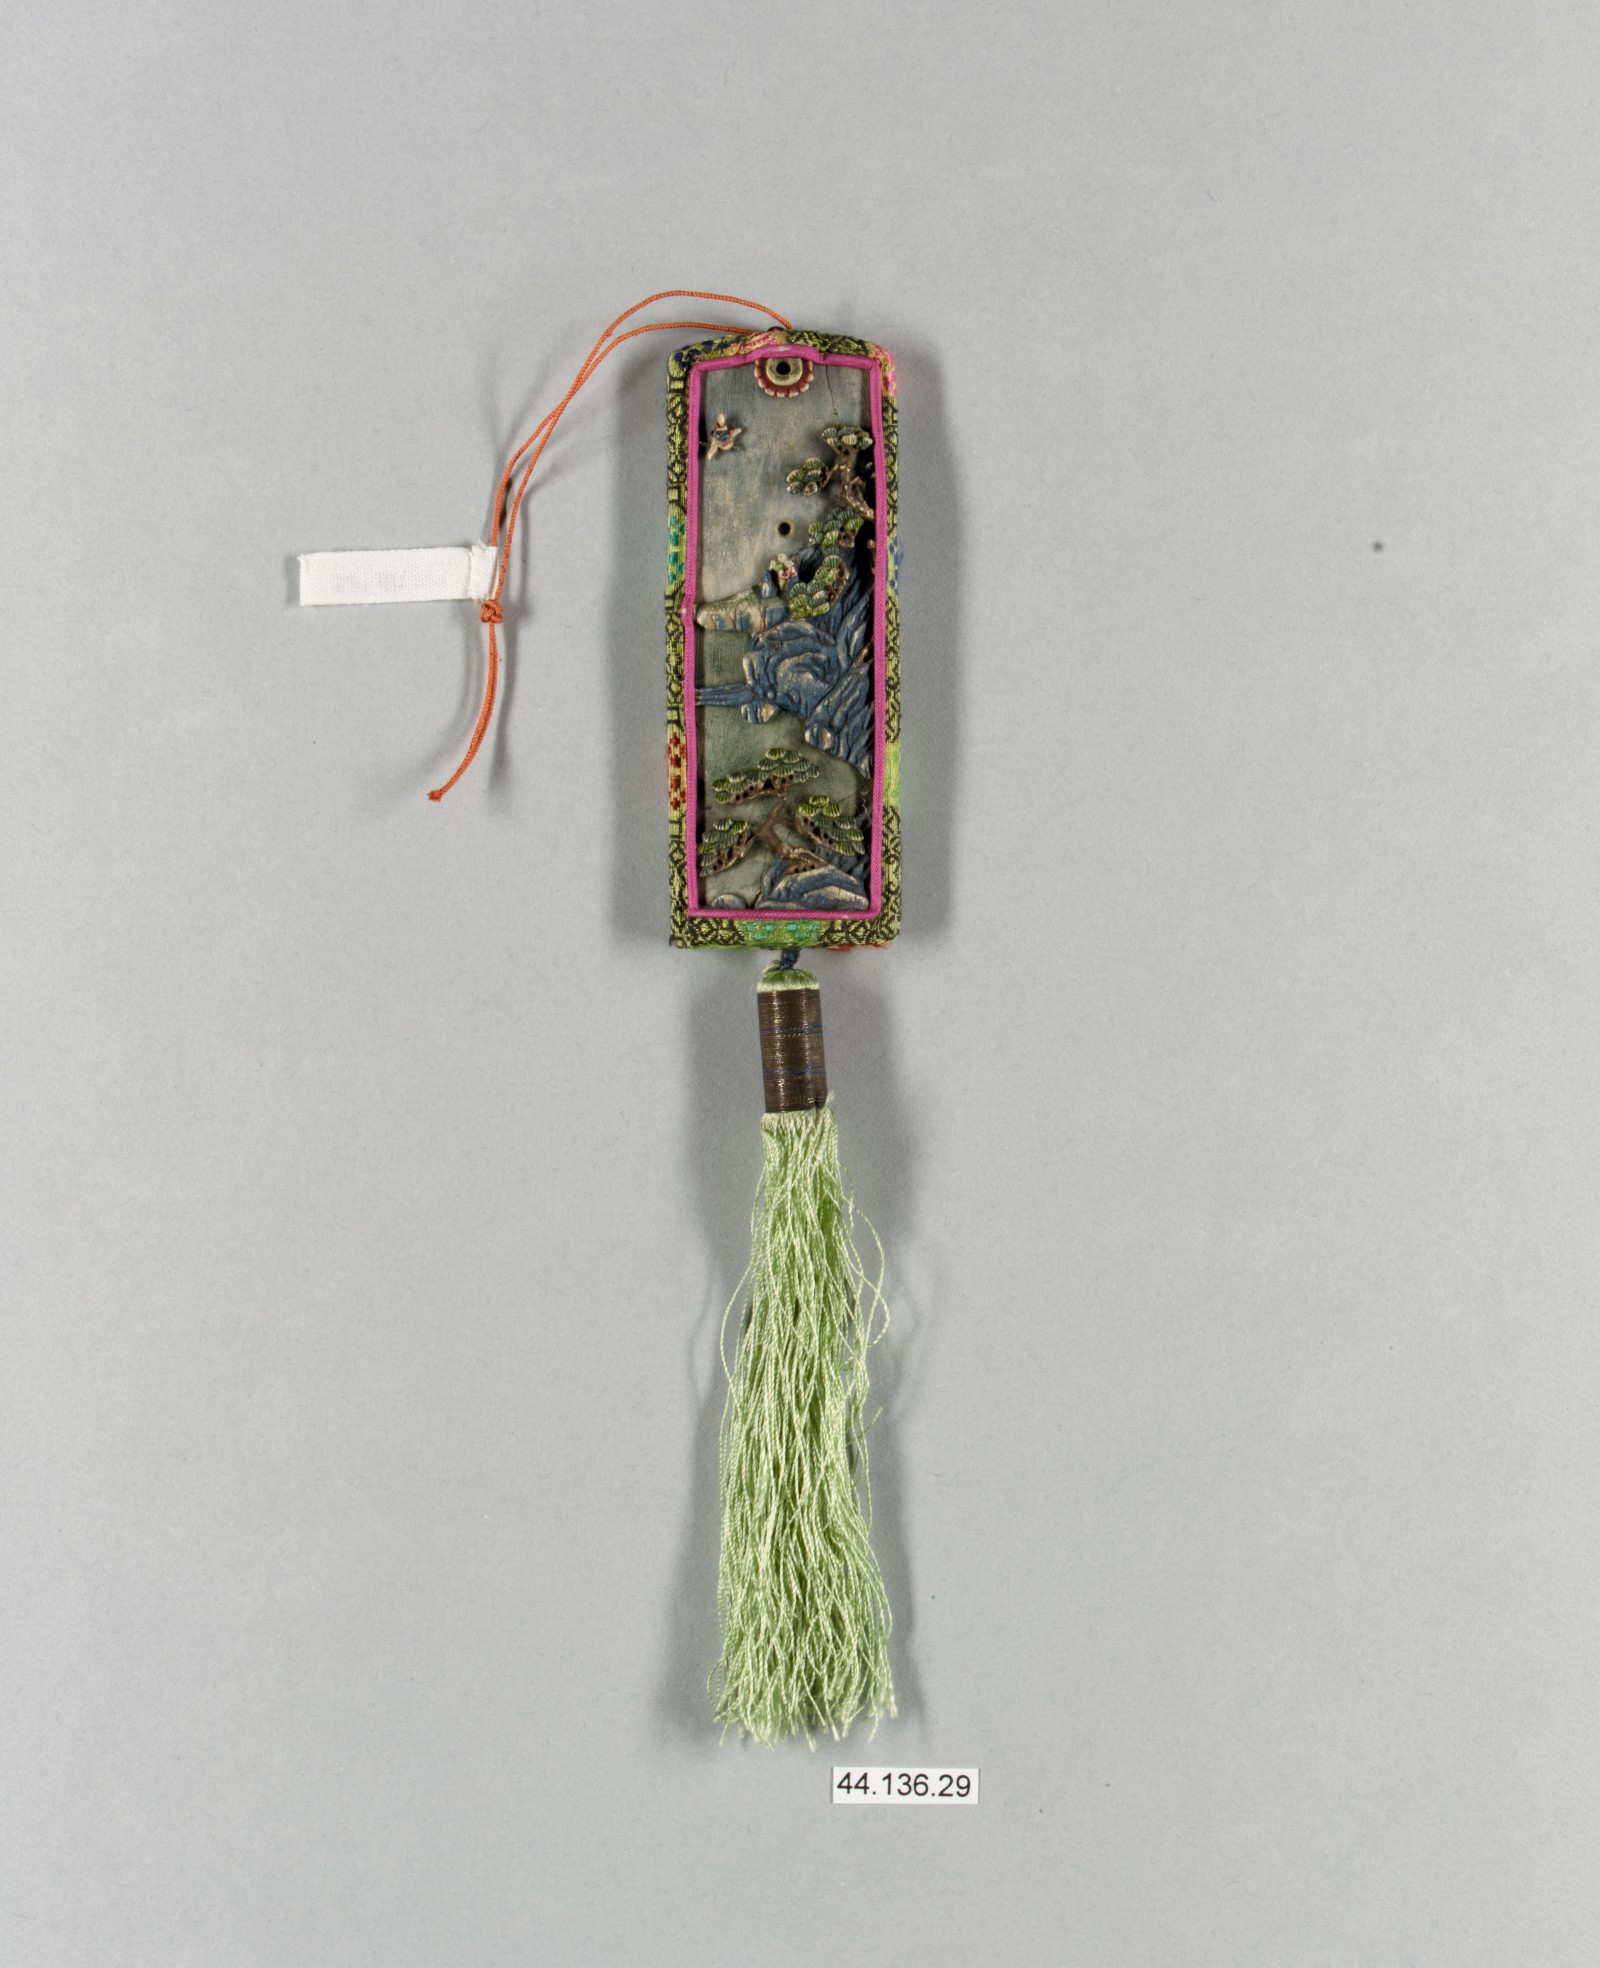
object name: mirror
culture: chinese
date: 1801-1900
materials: glass, ivory, silk, wood